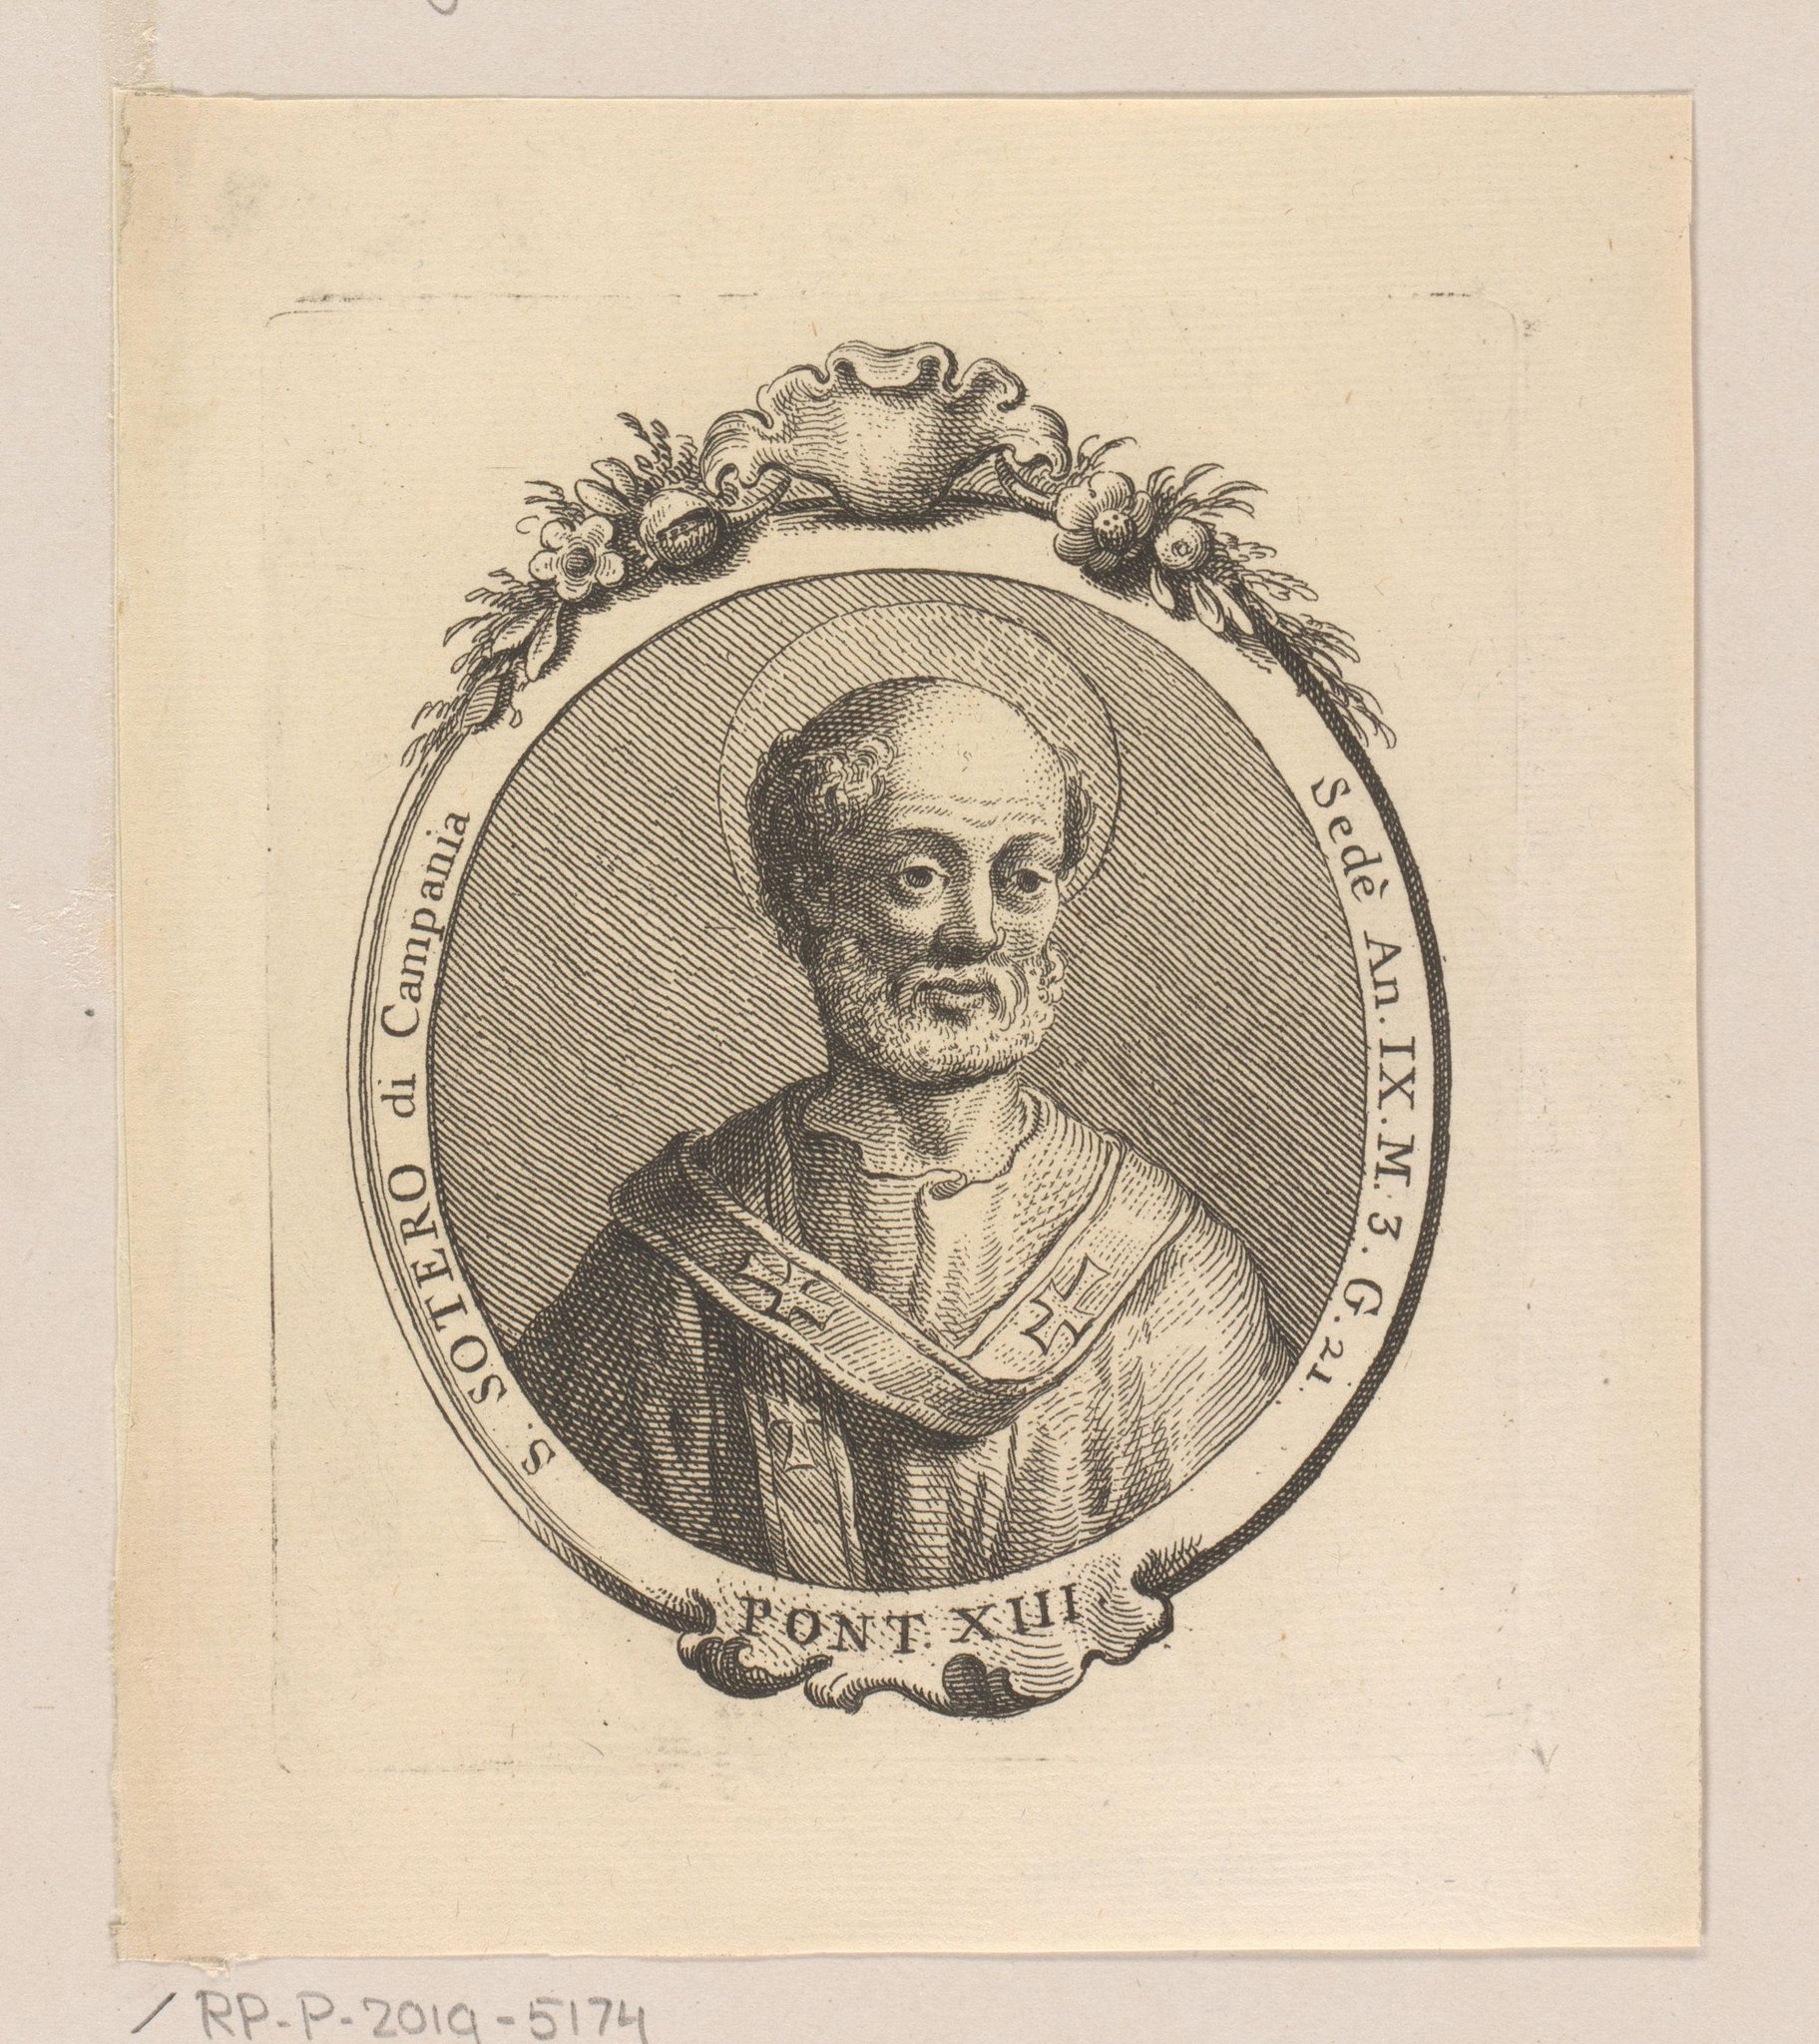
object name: book illustration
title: S. Sotero di Campinia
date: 1775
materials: paper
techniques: engraving, etching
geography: bassano del grappa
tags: rome, historical persons, pope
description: Prent uit: Effigies Romanorum pontificum a S. Petro ad Pium VI. feliciter regnantem (...). 2 dln. Venetië en Bassano del Grappa: Giuseppe Remondini, 1775.